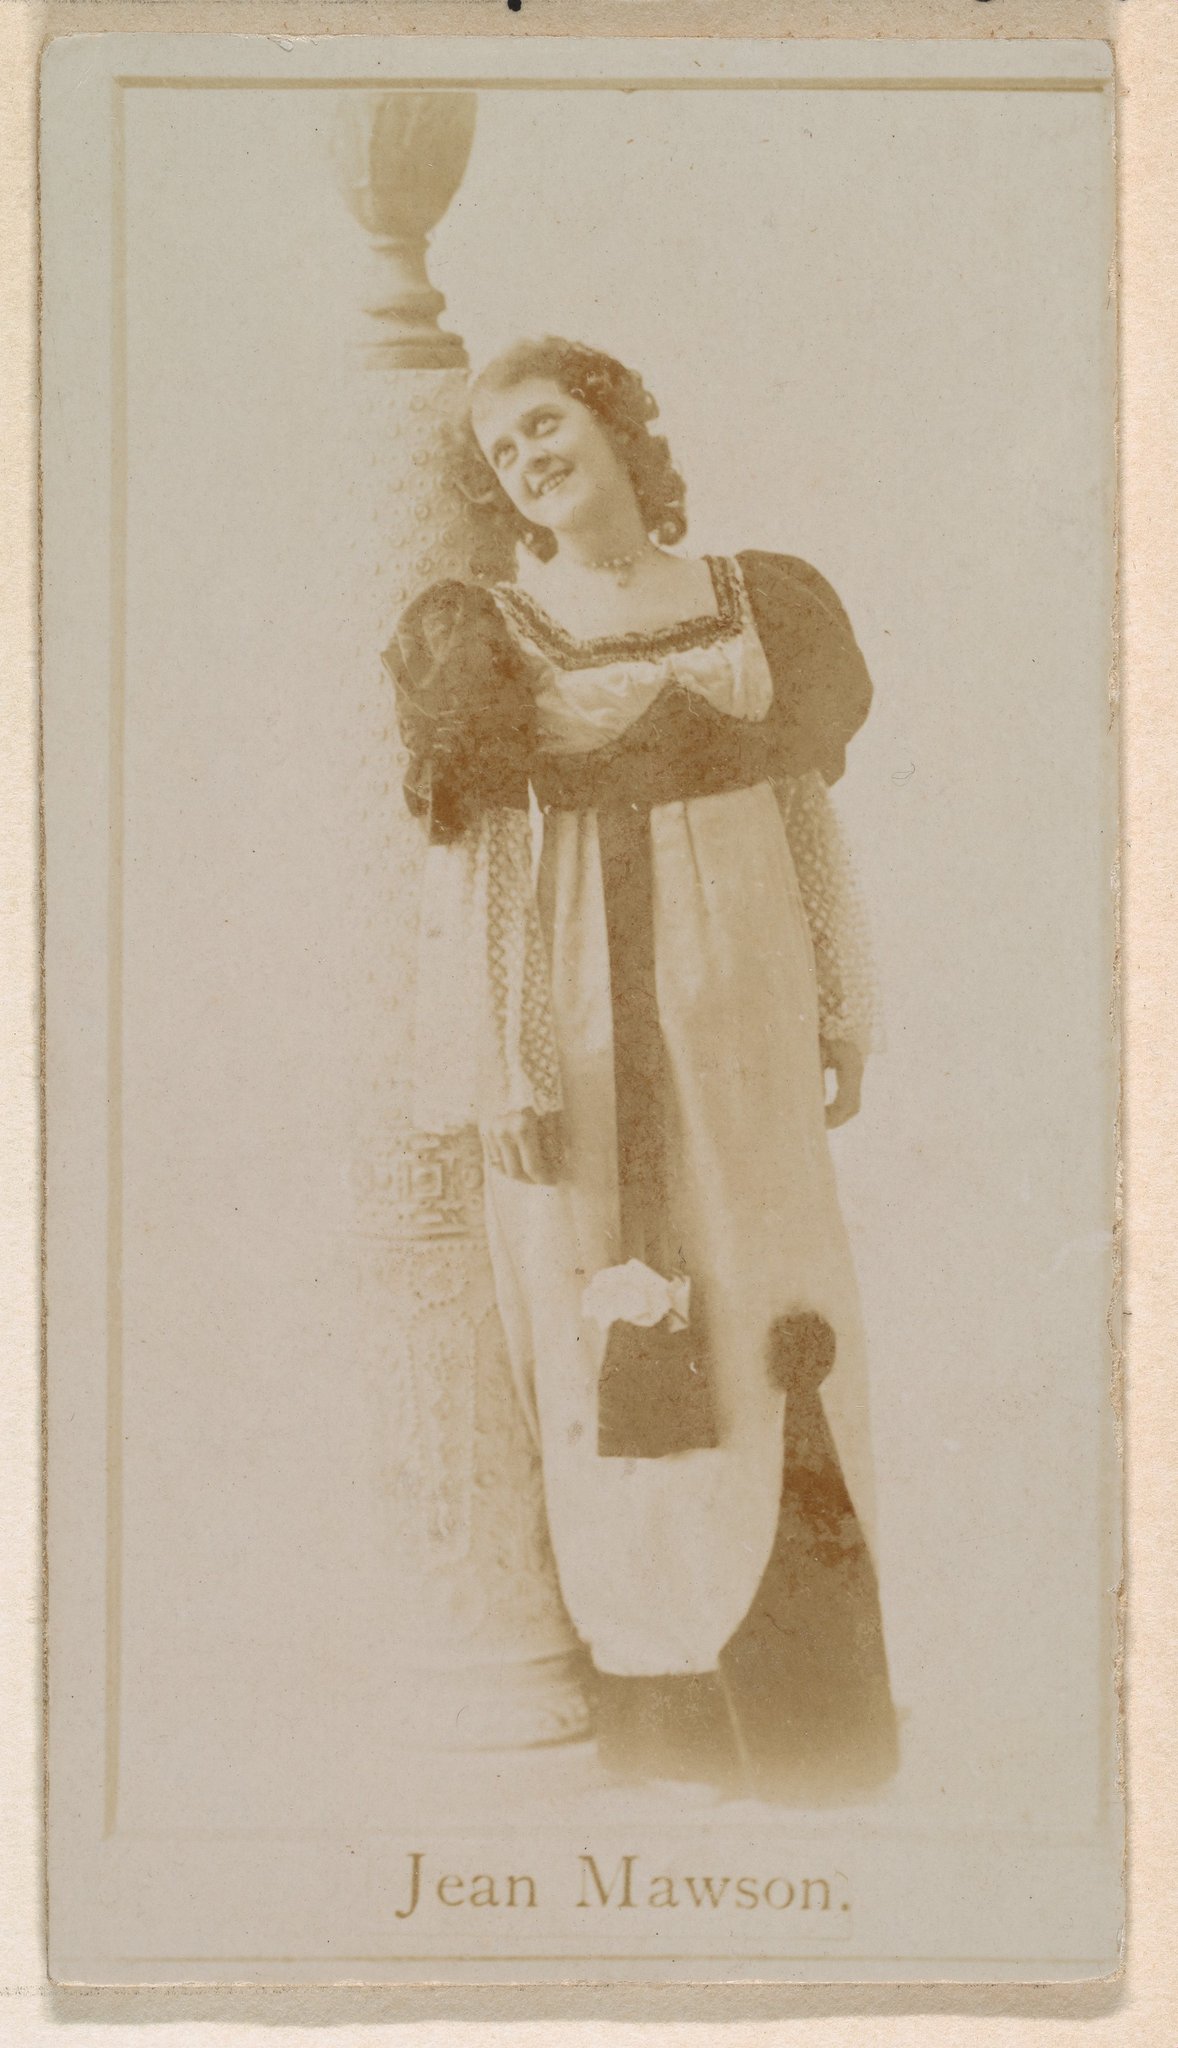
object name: photograph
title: Jean Mawson, from the Actresses series (N245) issued by Kinney Brothers to promote Sweet Caporal Cigarettes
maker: kinney brothers tobacco company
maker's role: publisher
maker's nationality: american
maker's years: 1869-2011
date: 1890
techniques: albumen silver print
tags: portraits,women,actresses